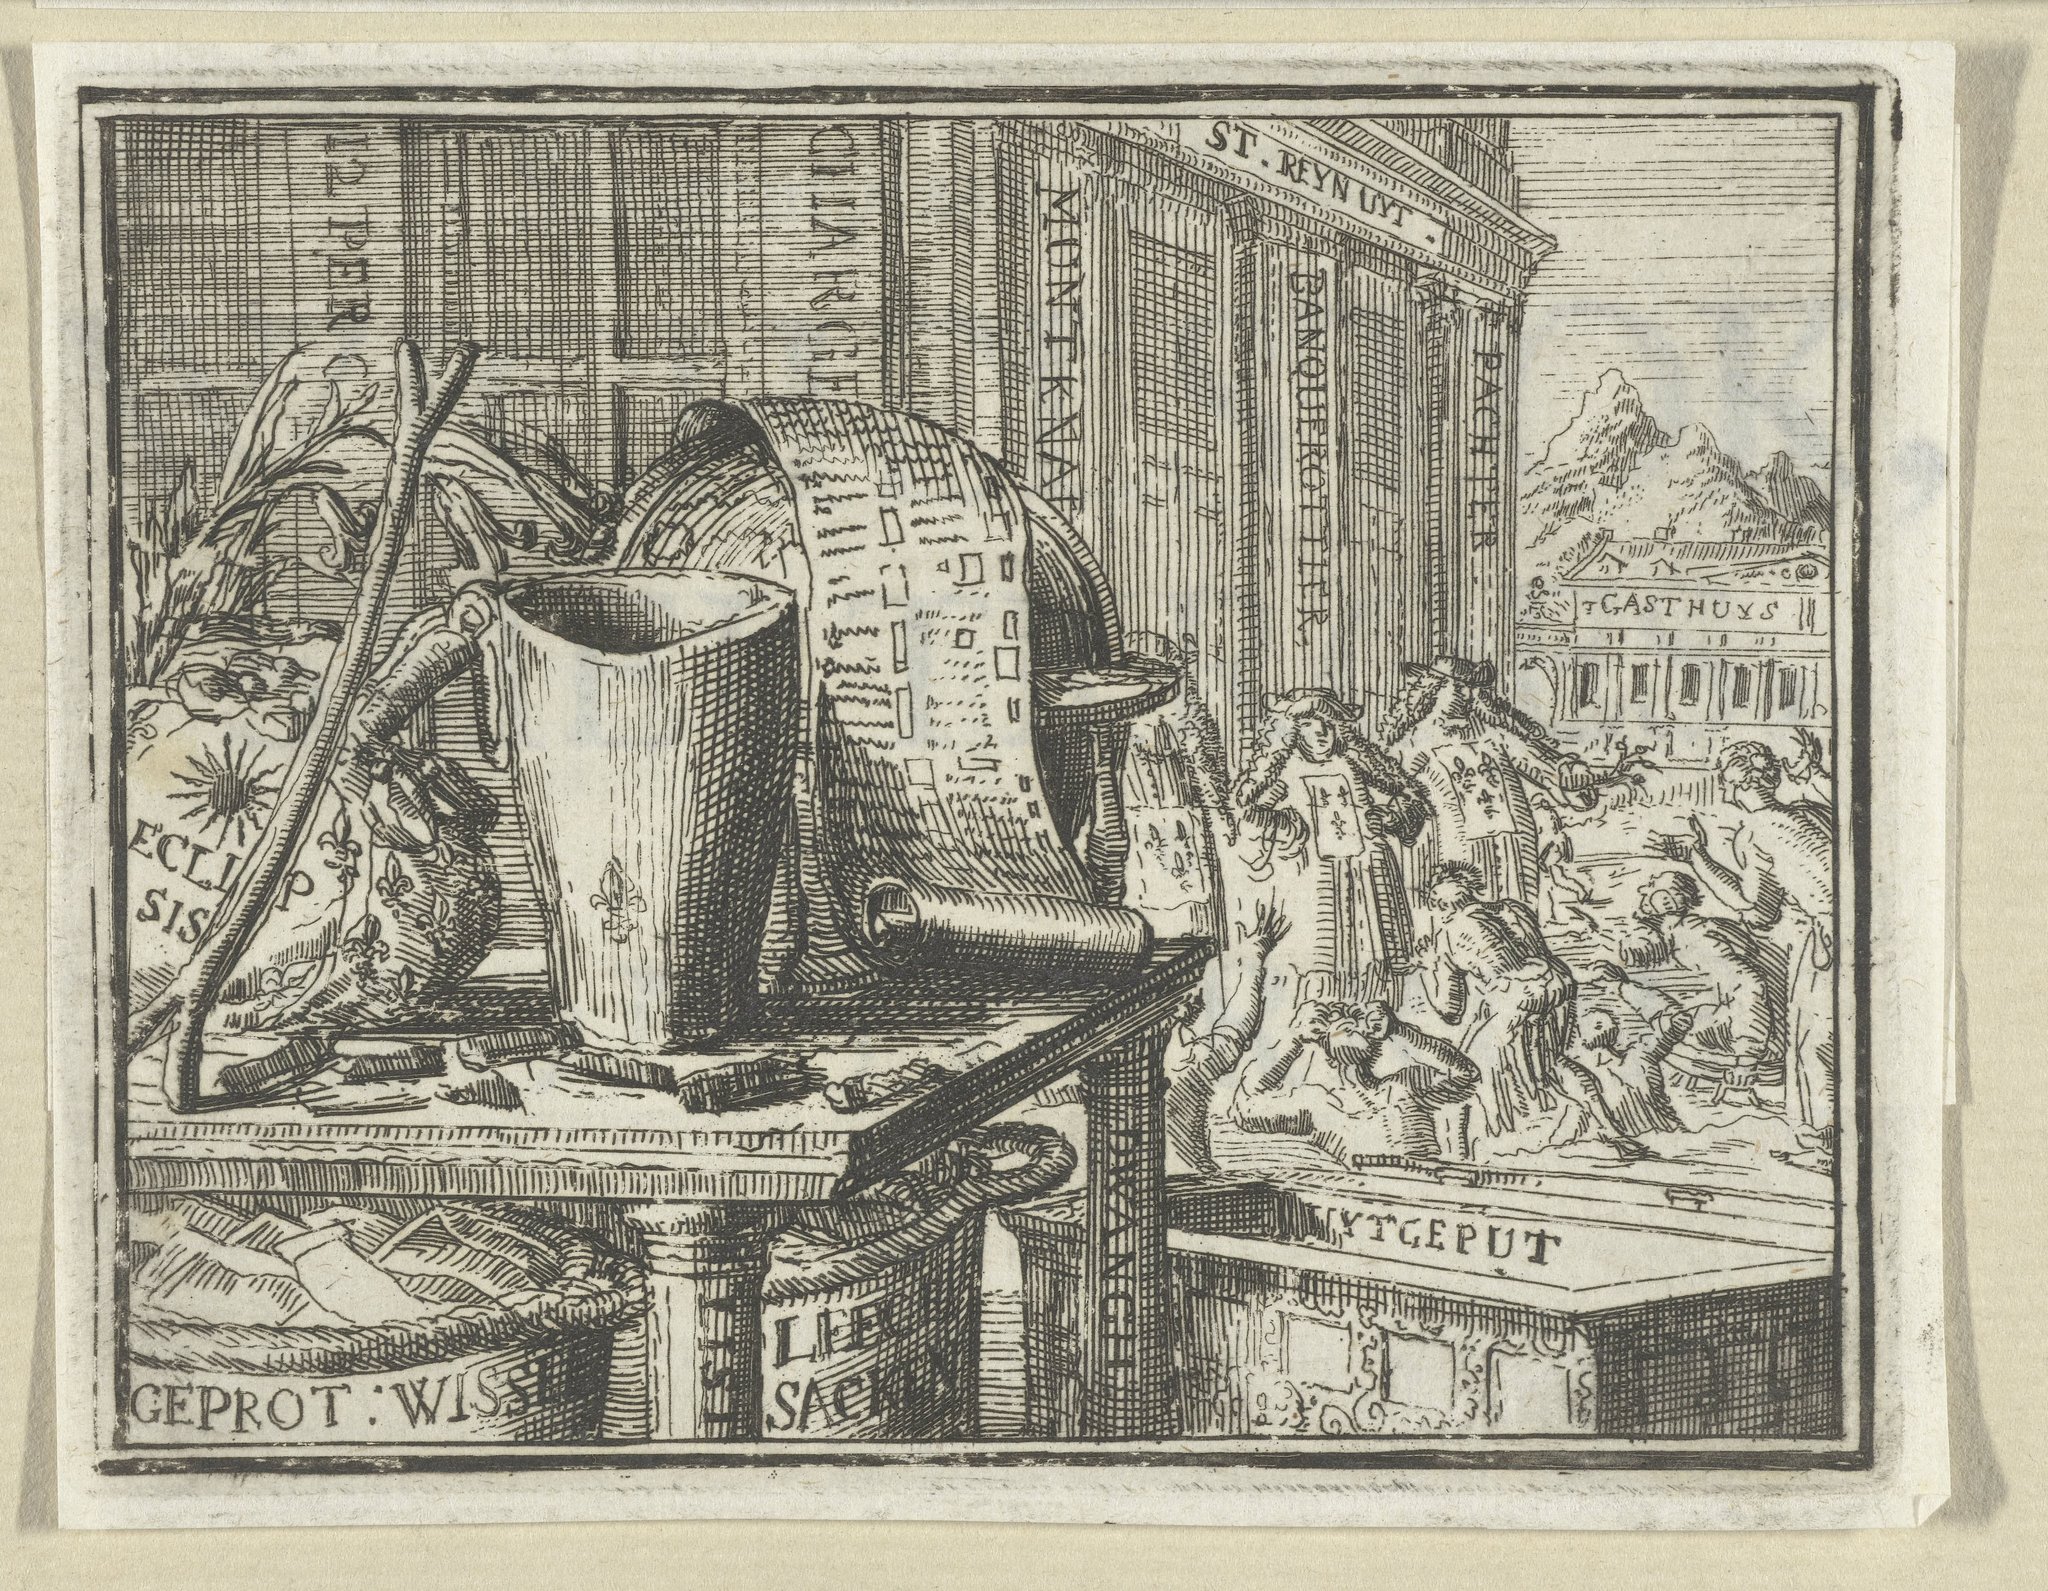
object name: print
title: Saamenspraak tusschen Wichelstok, Smeltkroes en de Monsterrol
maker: romeyn de hooghe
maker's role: draughtsman, goldsmith, painter, print maker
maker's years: 1645-1708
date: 1701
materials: paper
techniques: etching, letterpress printing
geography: netherlands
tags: divination with the aid of divining-rod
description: Tafel met een smeltkroes, geldbuidel, papieren rol en een wichelroede. Op de grond een lege schatkist. Spotprent op de slecht staat van de der Franse financiën en het omsmelten van kerkschatten en particiliere serviezen. Titel staat op apart tekstblad.